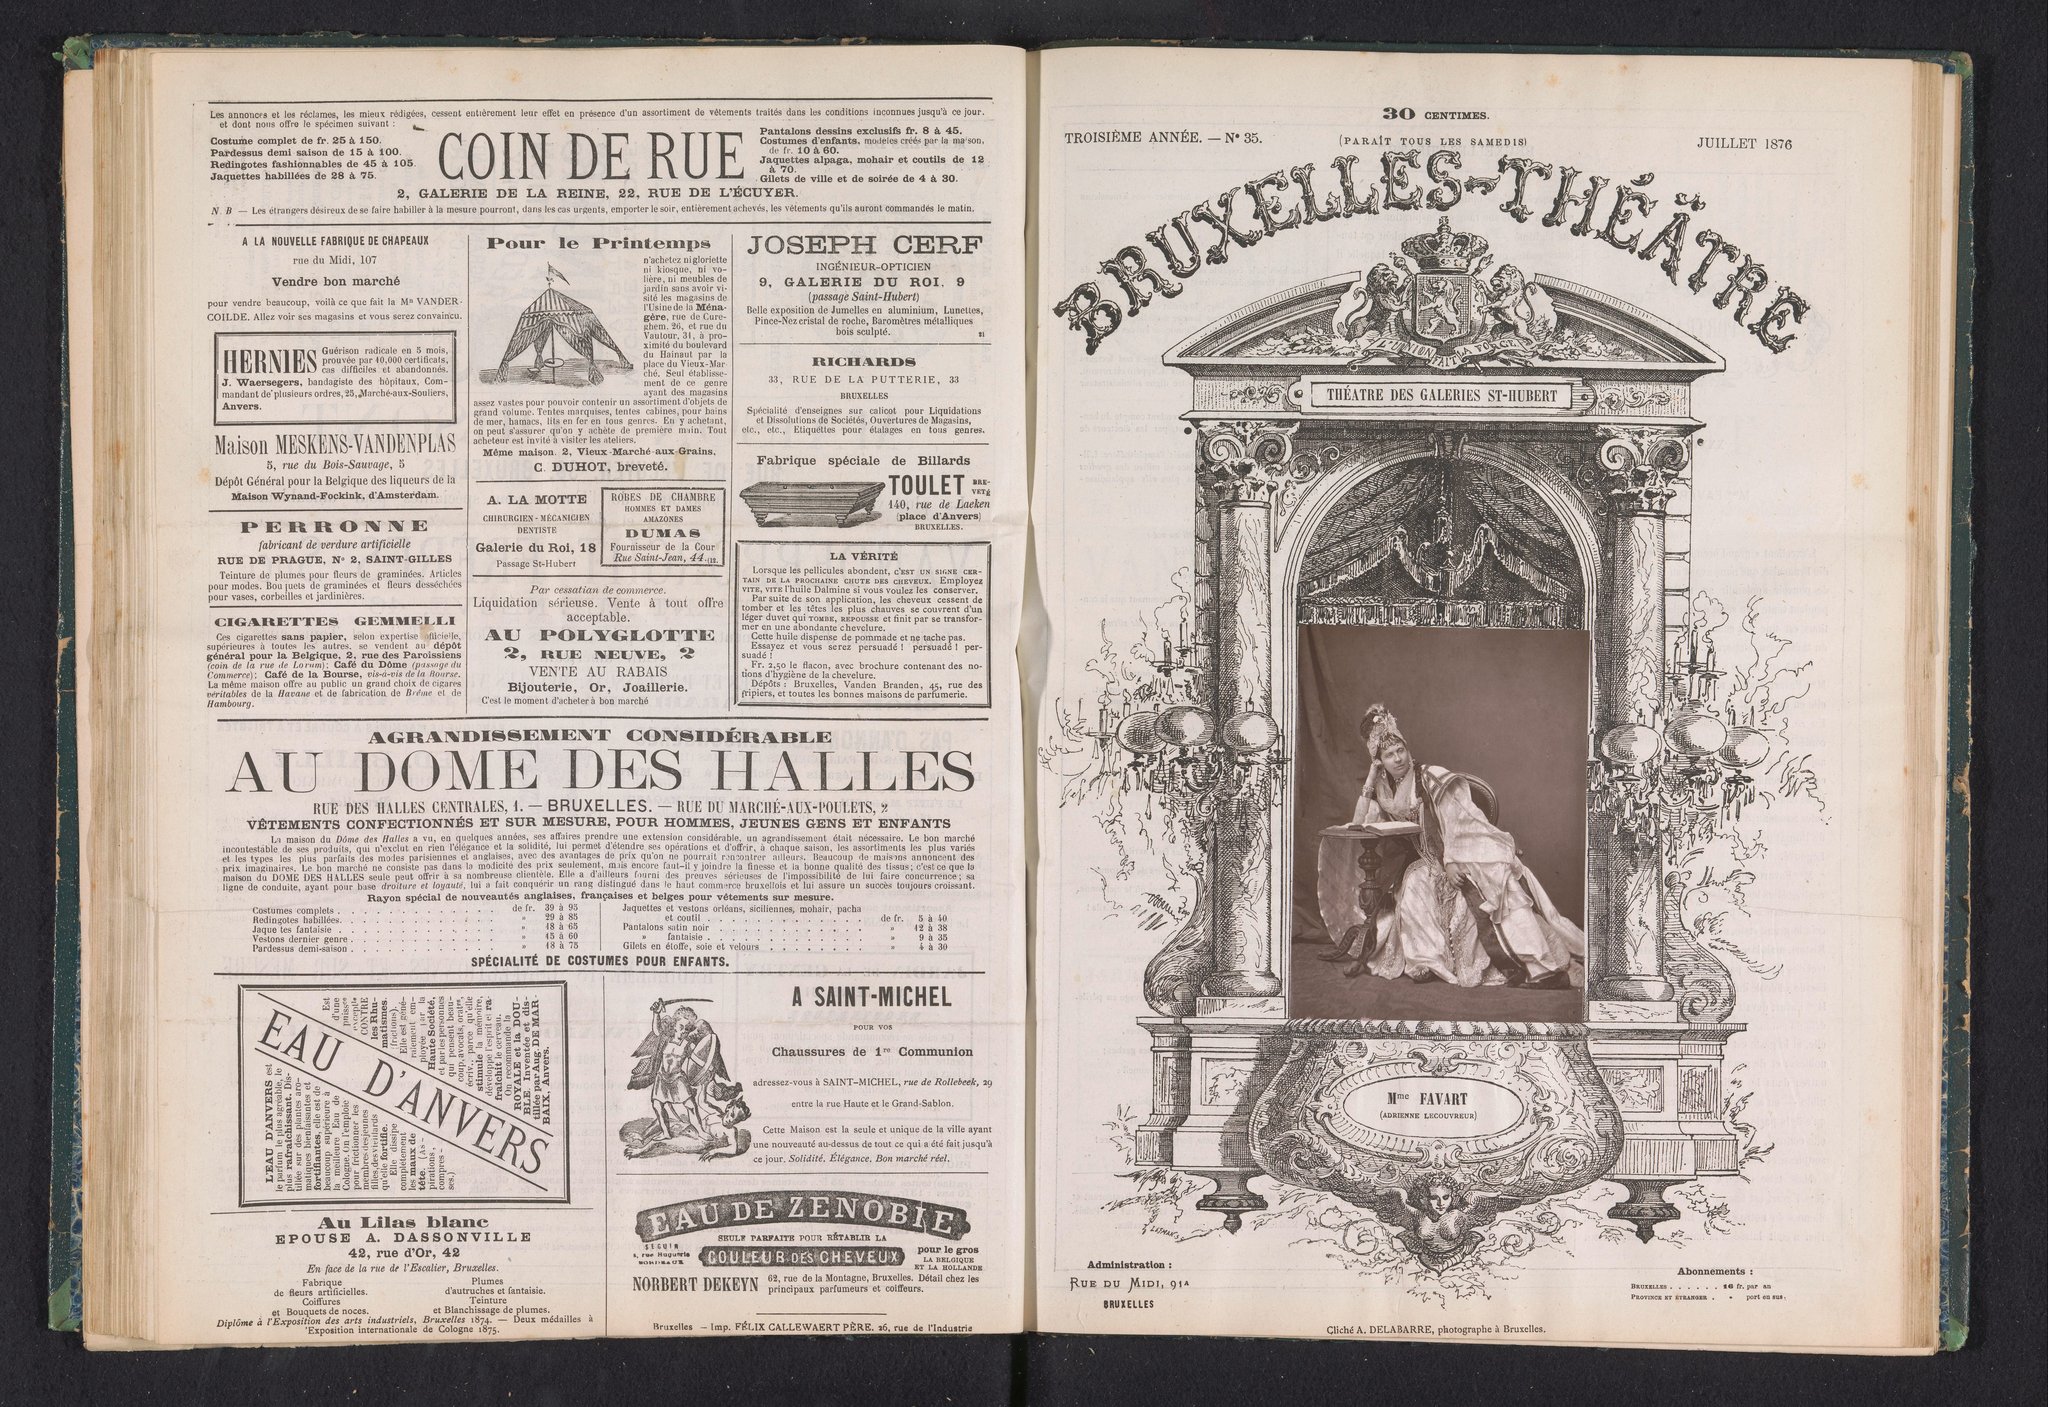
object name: photomechanical print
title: Portret van Maria Favart in Adrienne Lecouvreur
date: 1871-1876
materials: paper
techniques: woodburytype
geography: brussels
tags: paris, portrait of actor, actress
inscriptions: number: ‘No 35.’